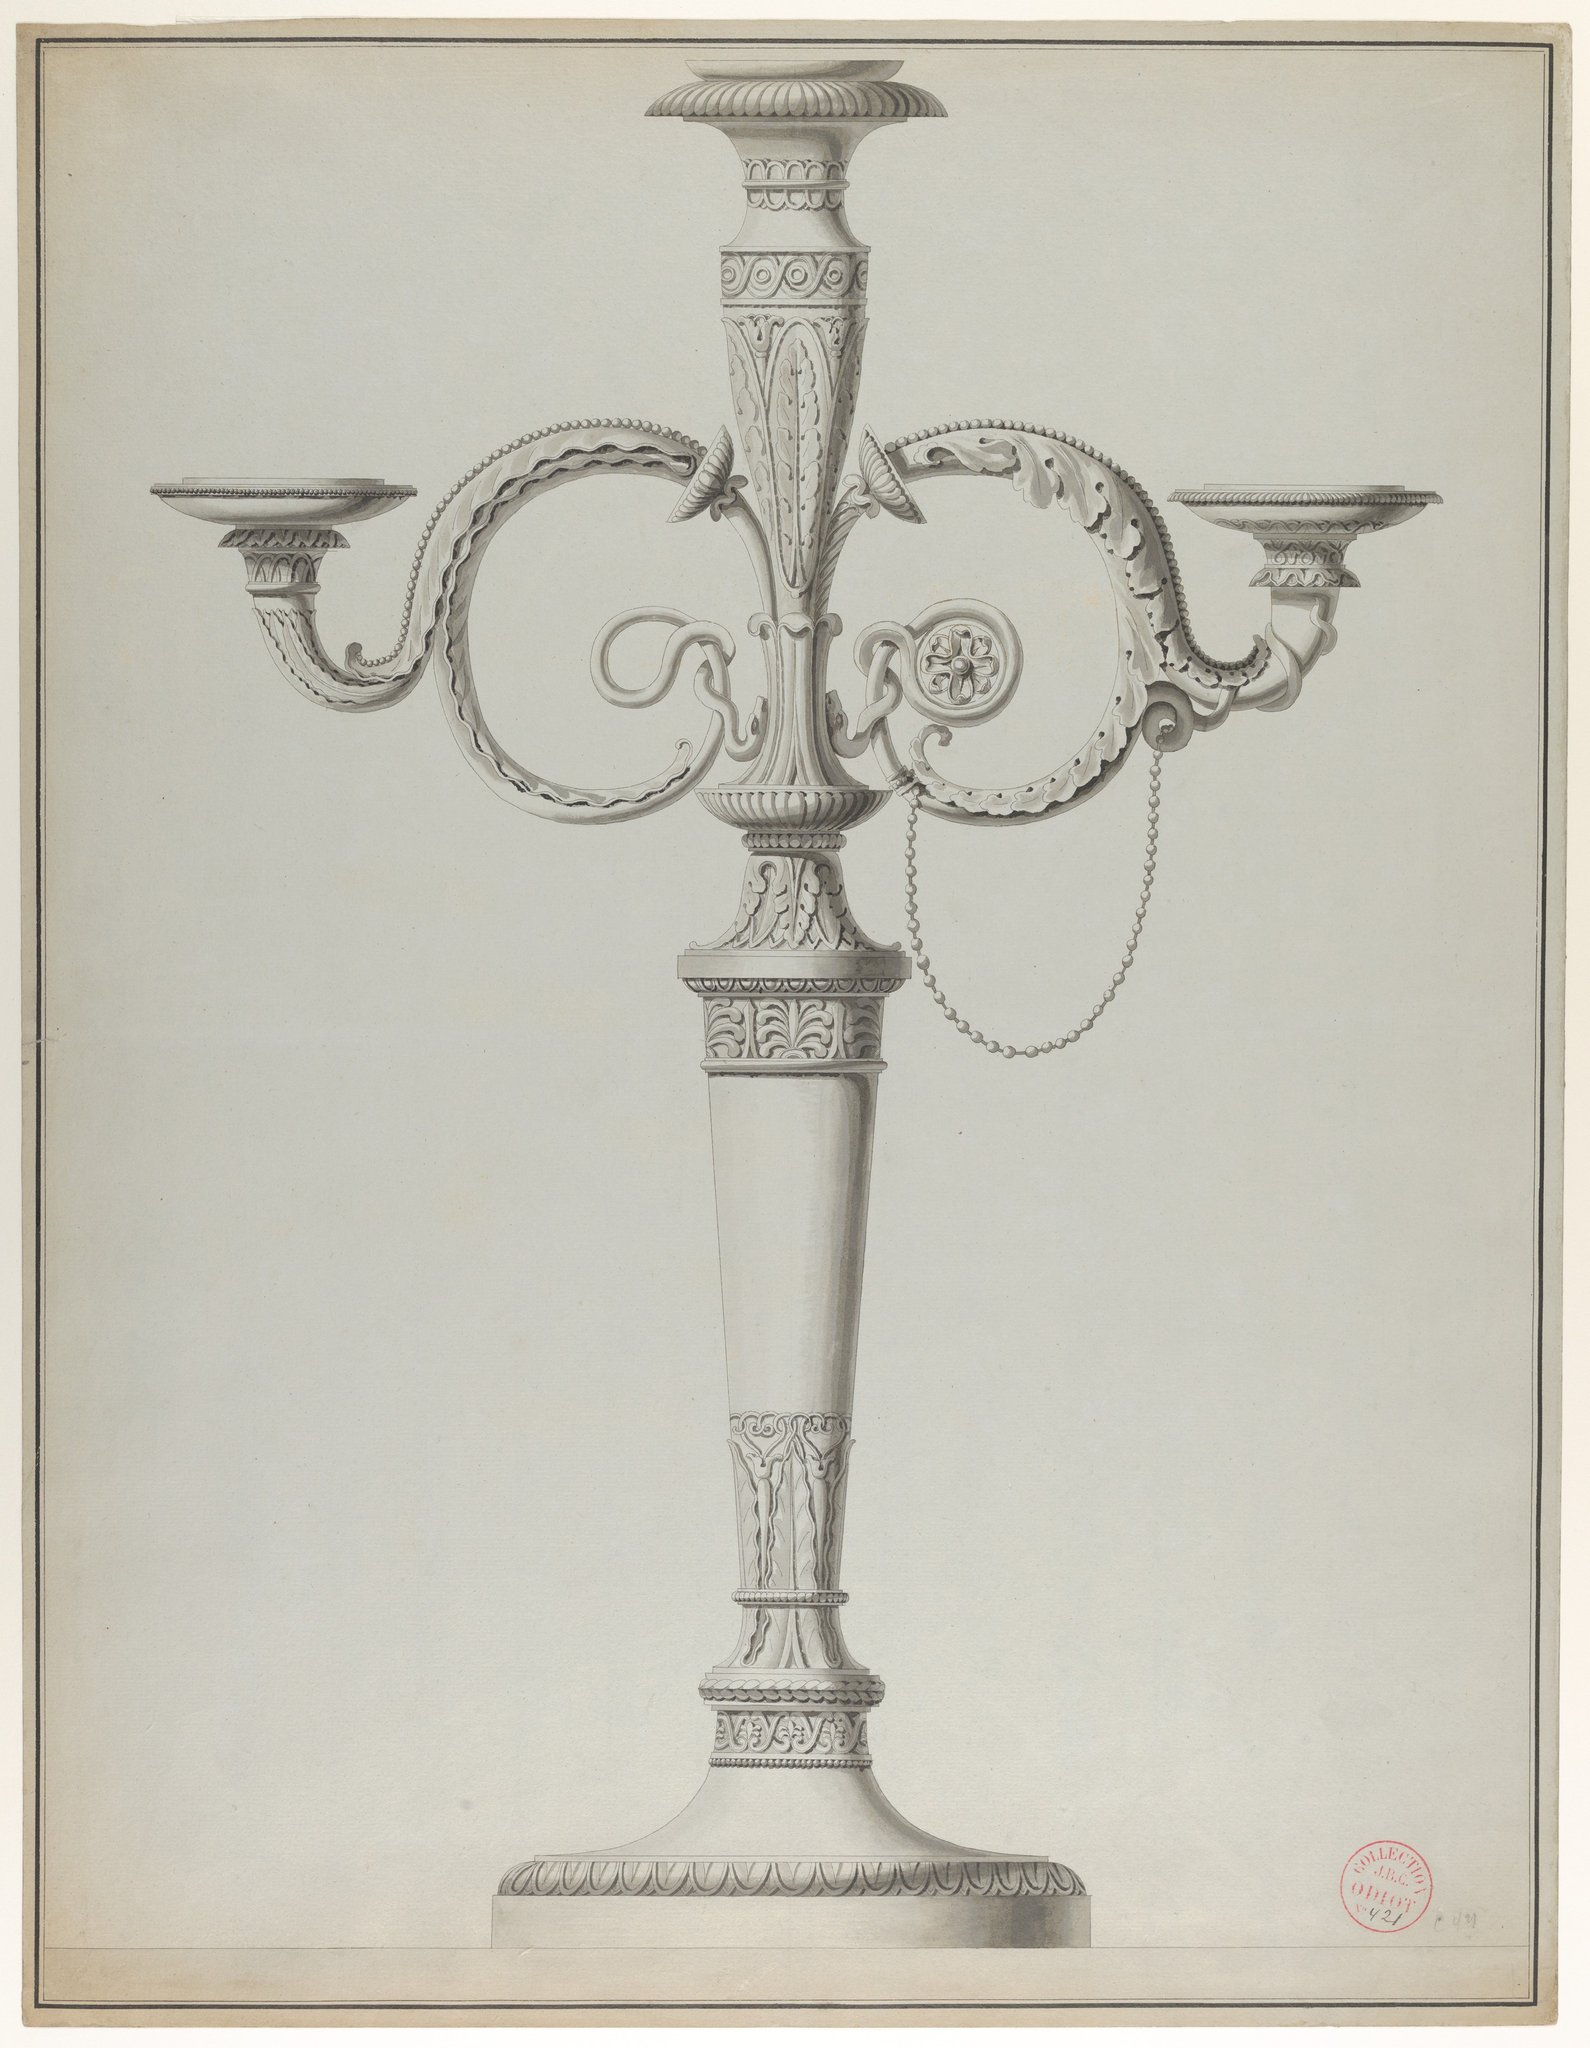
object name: drawing ornament architecture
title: Candelabrum with Alternative Designs for the Arms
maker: henri auguste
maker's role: artist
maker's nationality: french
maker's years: 1759-1816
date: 1770-1800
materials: ink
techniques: brush, pen, wash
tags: candelabra